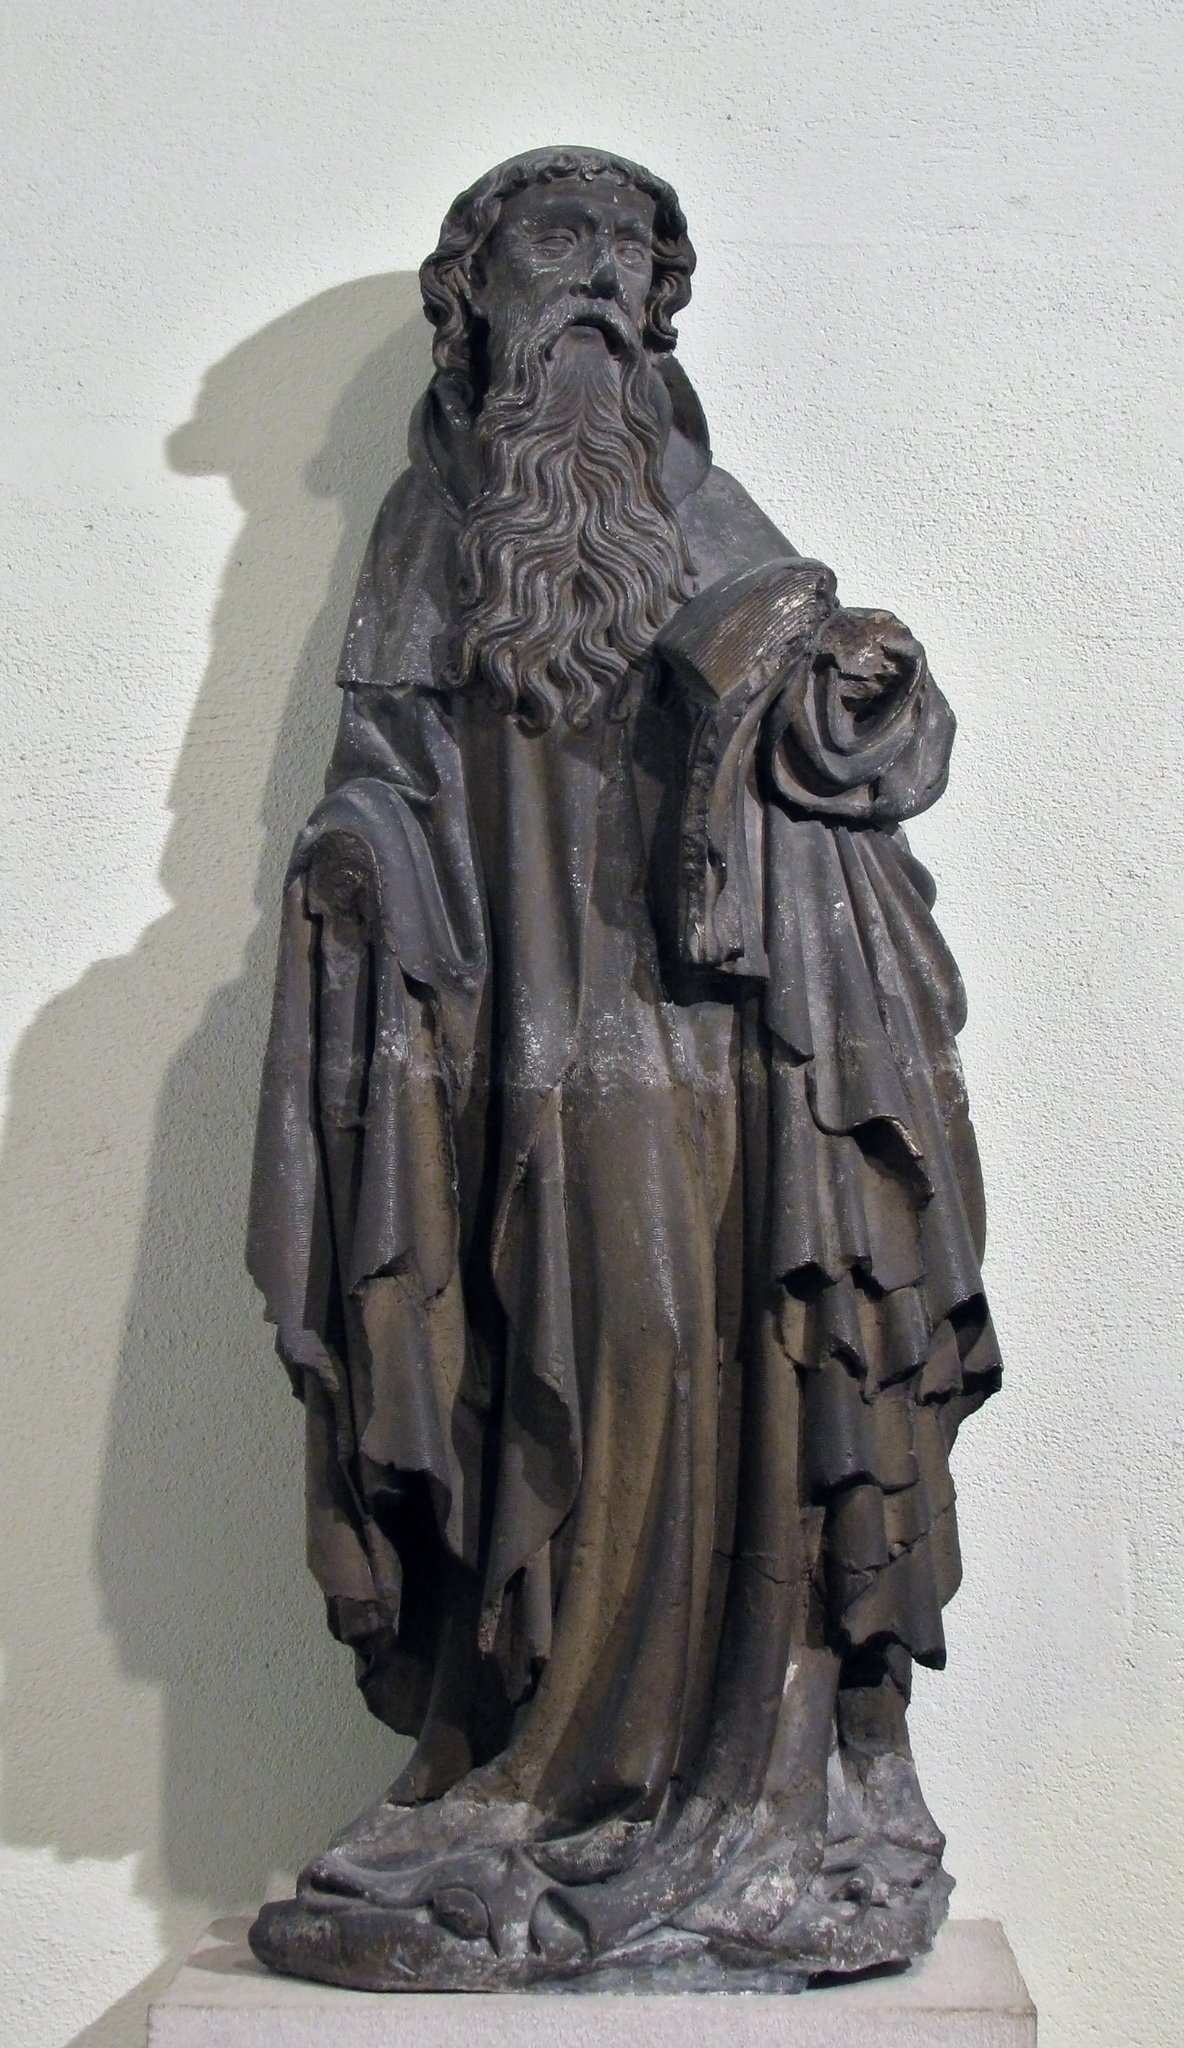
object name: statue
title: Standing Saint or Apostle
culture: french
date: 1367-1400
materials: limestone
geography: france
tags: men,apostles,saints